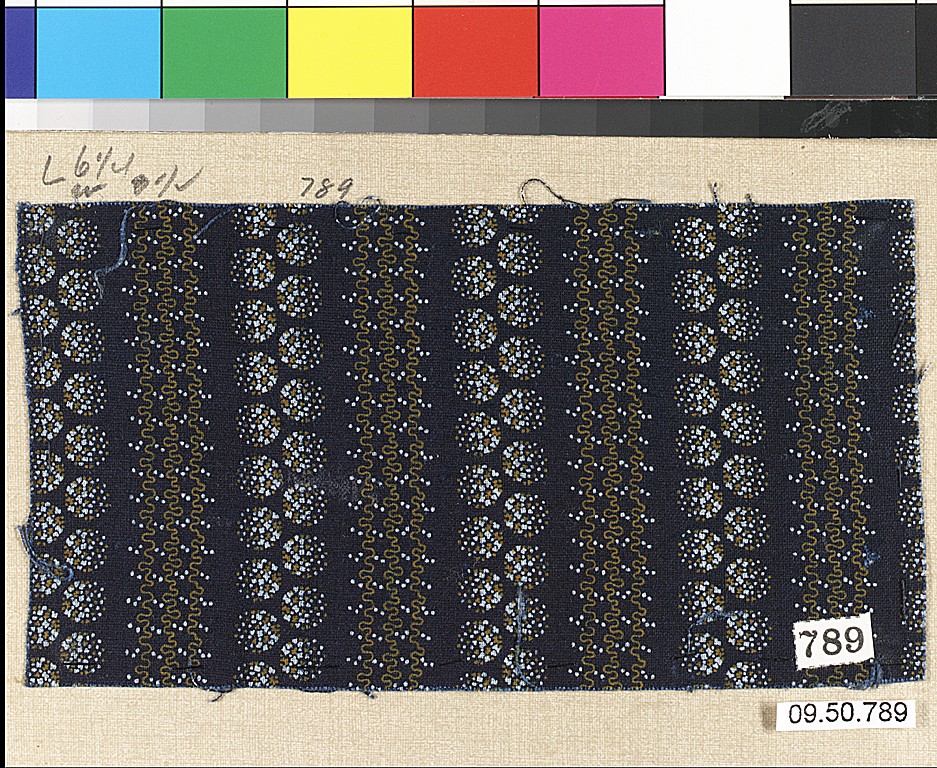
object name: piece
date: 1801-1900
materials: cotton